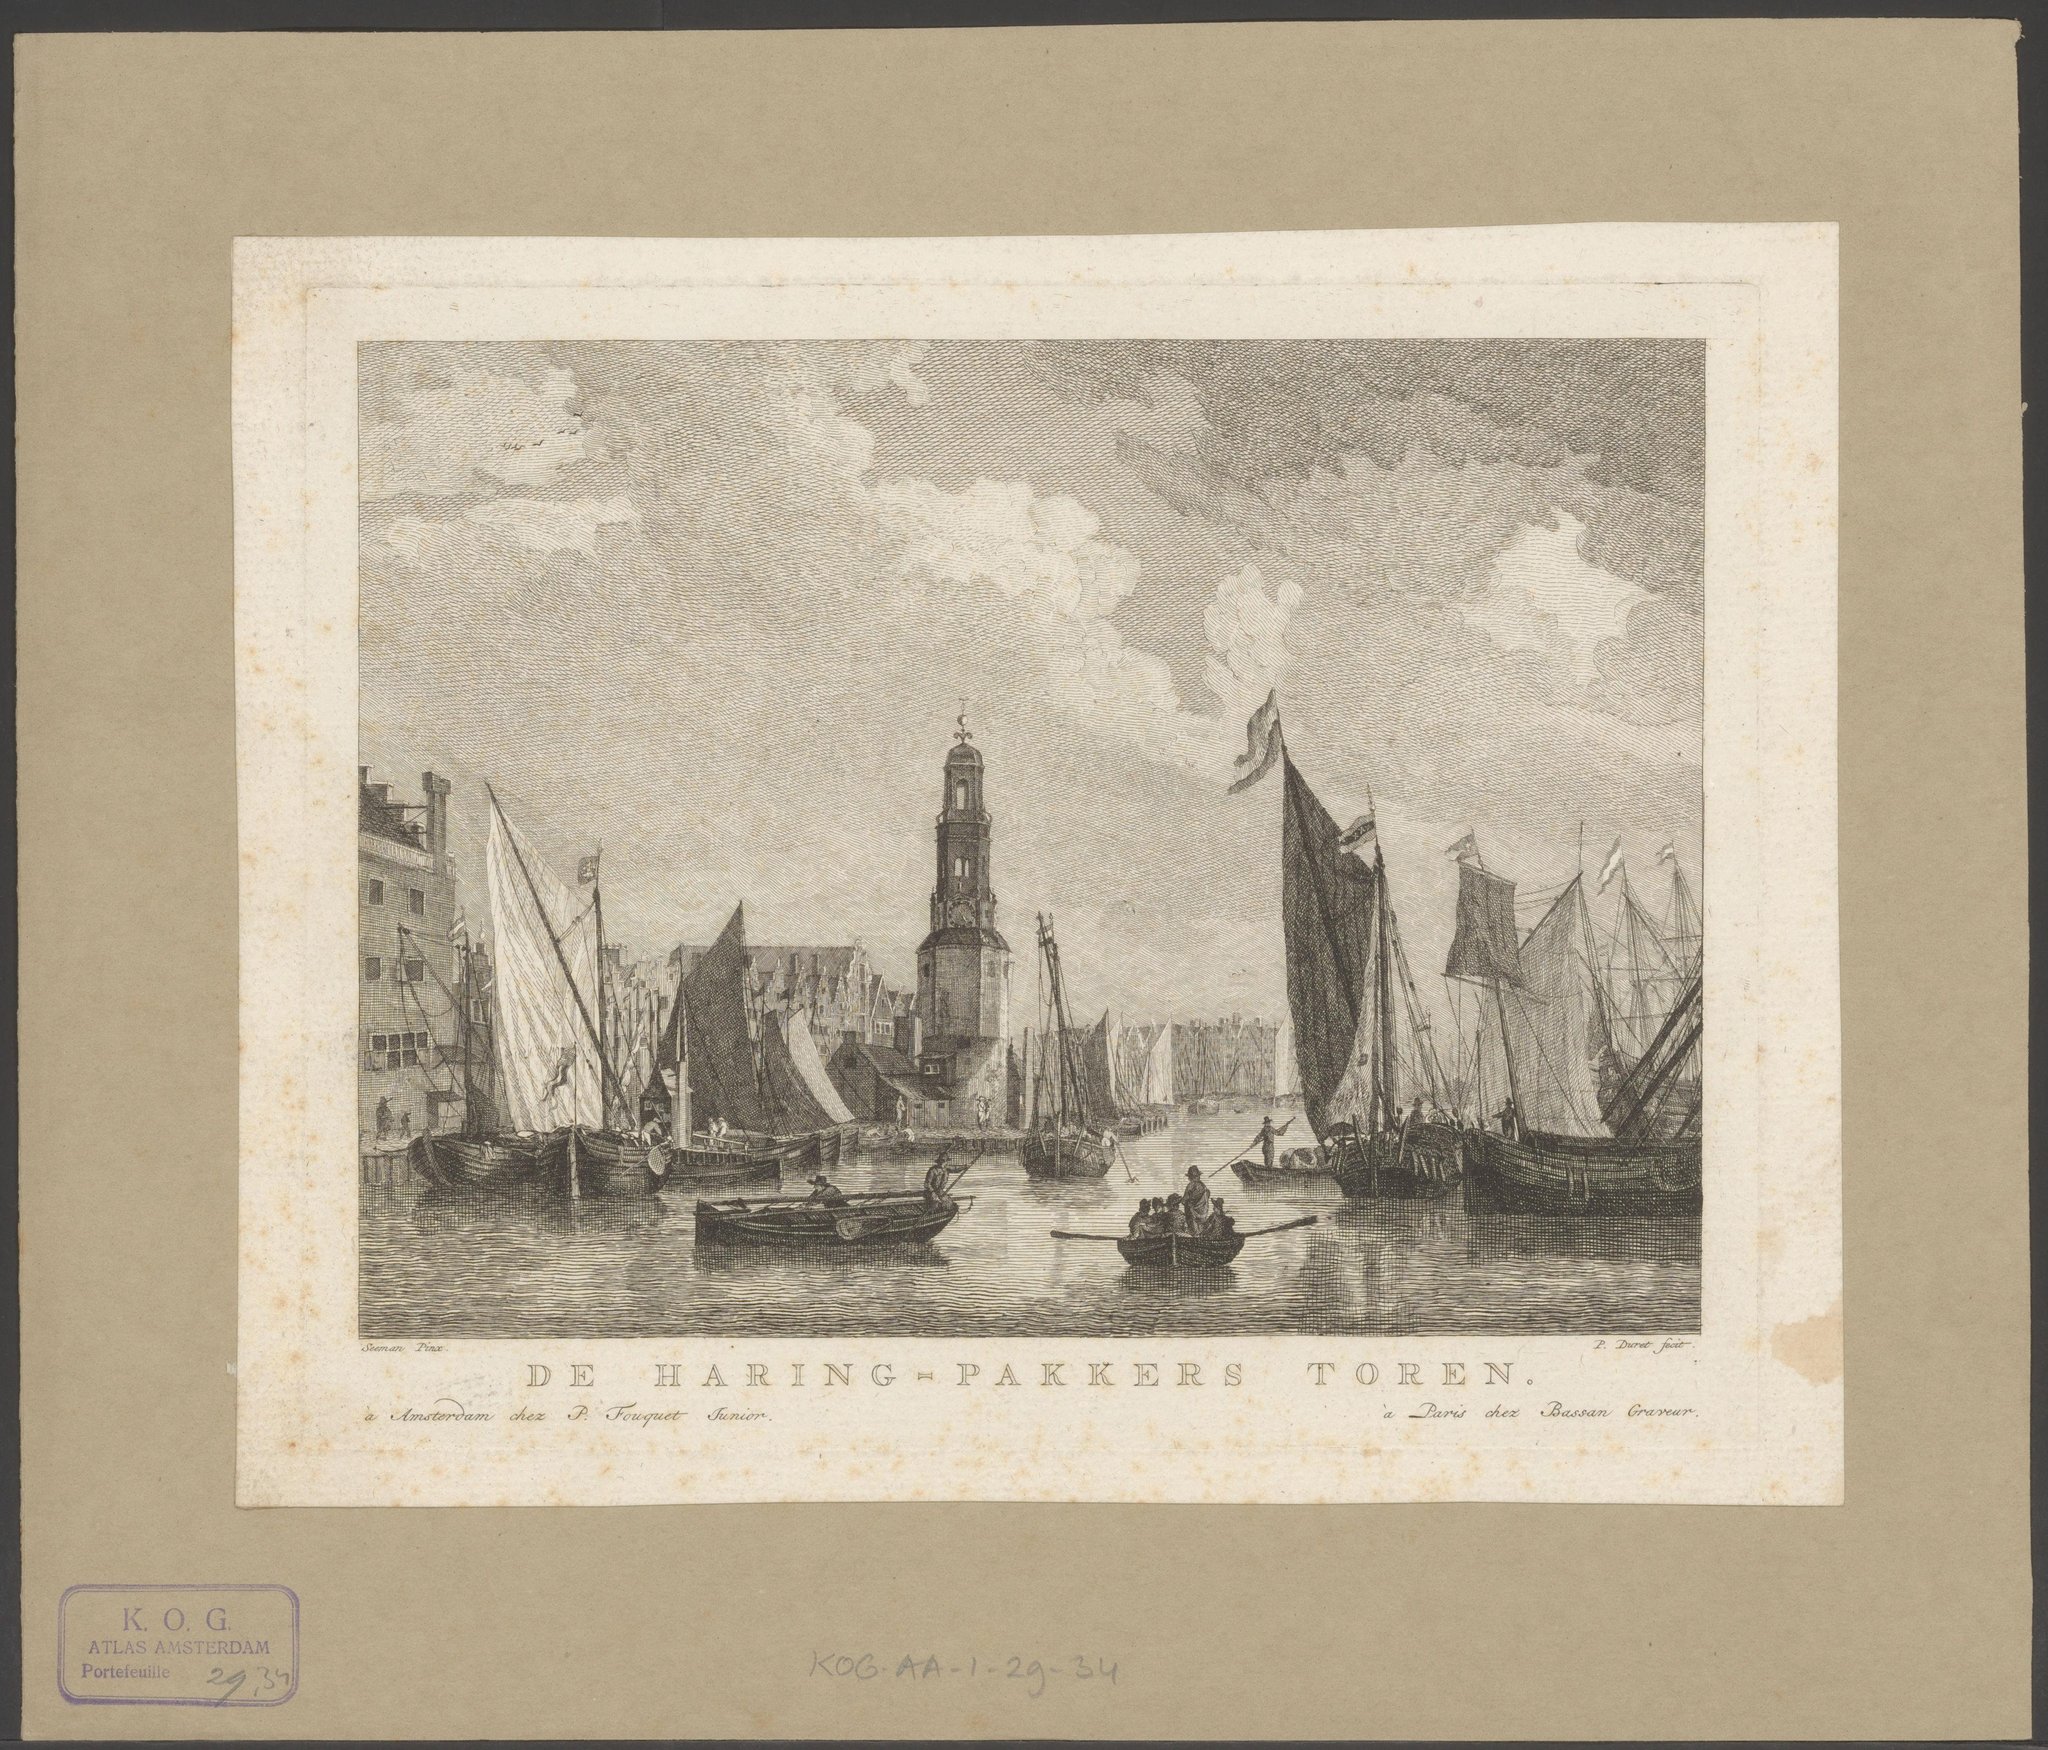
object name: print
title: De Haring-Pakkers Toren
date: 1753-1797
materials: paper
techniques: engraving, etching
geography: paris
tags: sailing-ship, sailing-boat, tower, clock tower ~ monumental adornment, rowing-boat, canoe, etc., canals, waters (in city) (+ city(-scape) with figures, staffage)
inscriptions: collector's mark: Lugt 1641b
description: Vermoedelijk de pendant van een gezicht op de Montelbaanstoren, zie KOG-AA-1-29-72B.